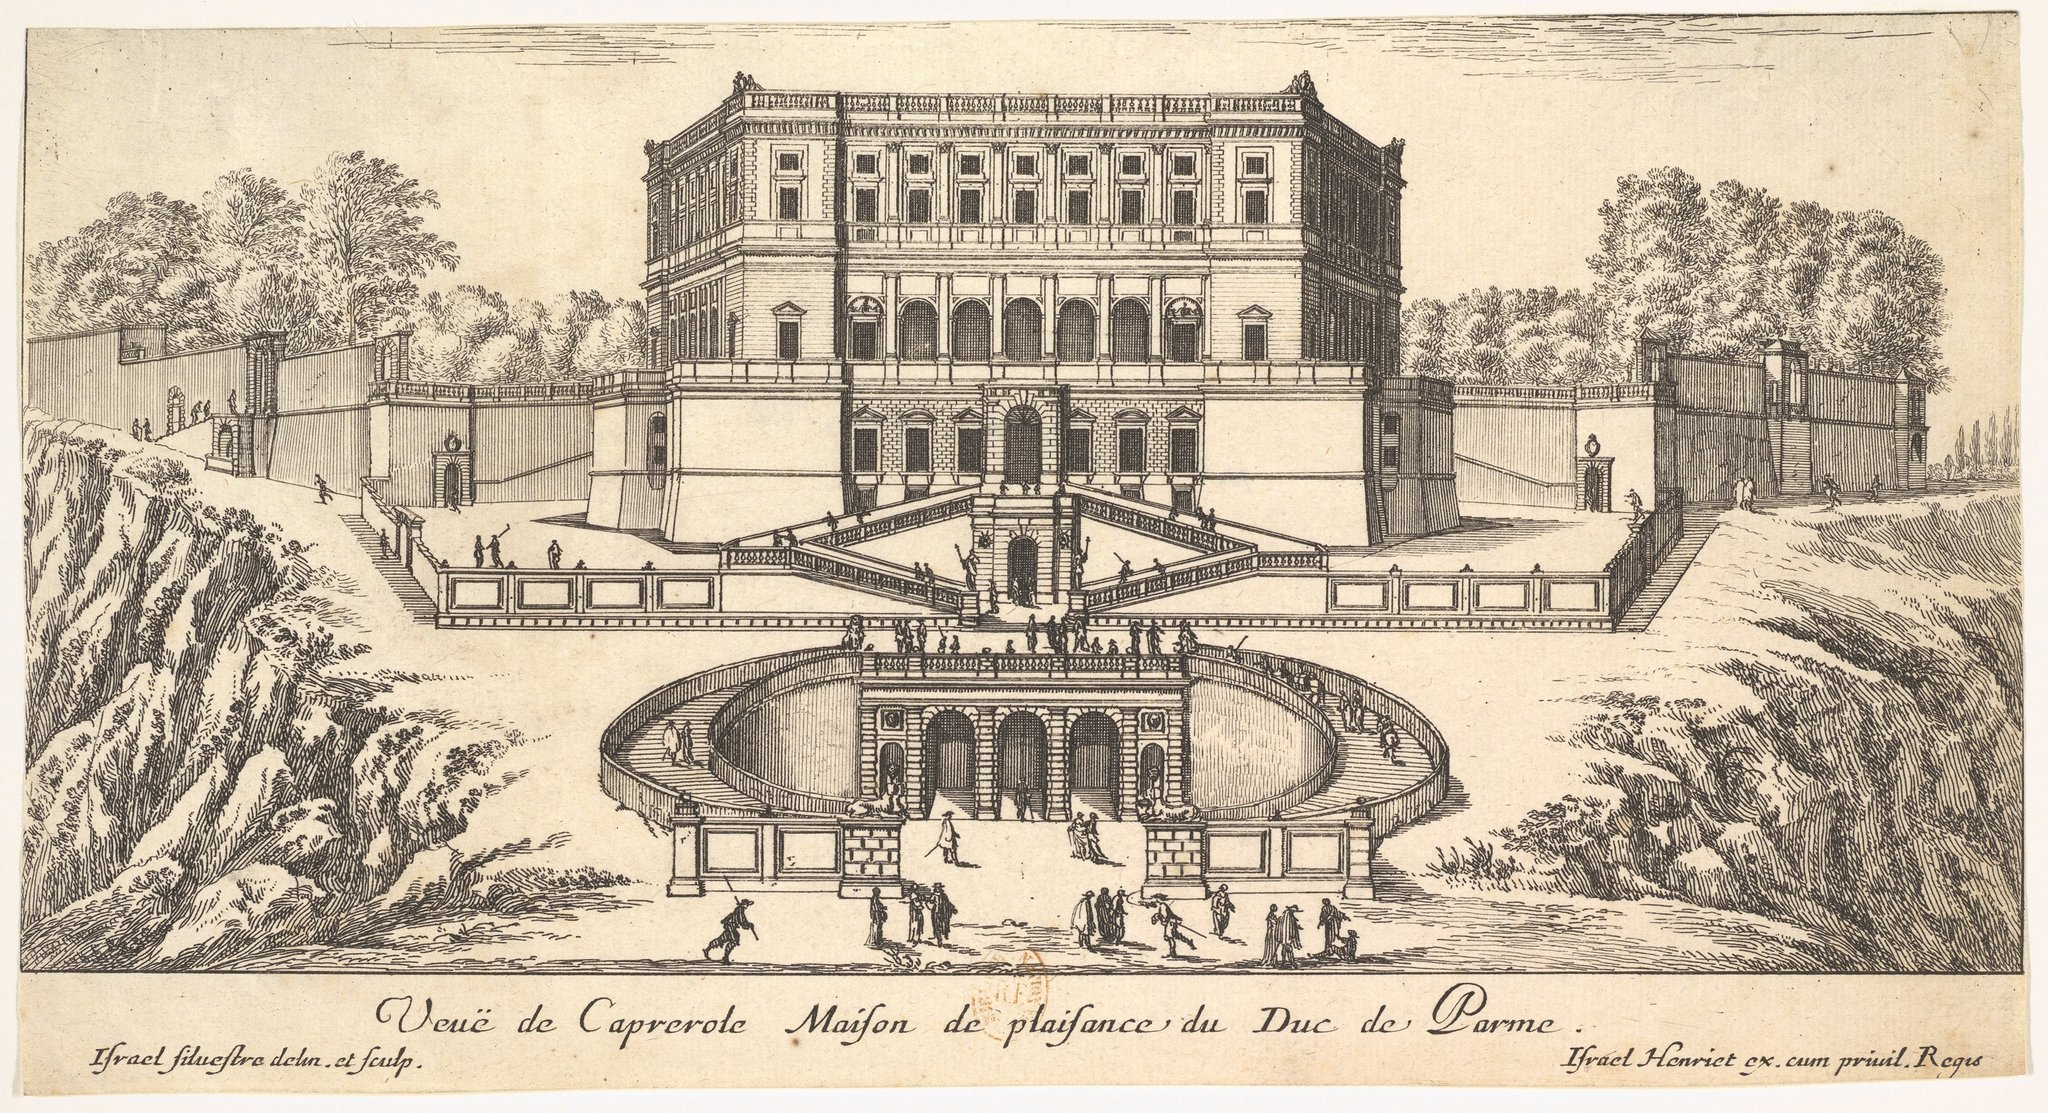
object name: print ornament architecture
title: View of Caprarola, from "Fifteen Views of Italy and France"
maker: israël silvestre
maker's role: artist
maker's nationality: french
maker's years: 1621-1691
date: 1601-1700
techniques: etching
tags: human figures,buildings,towns